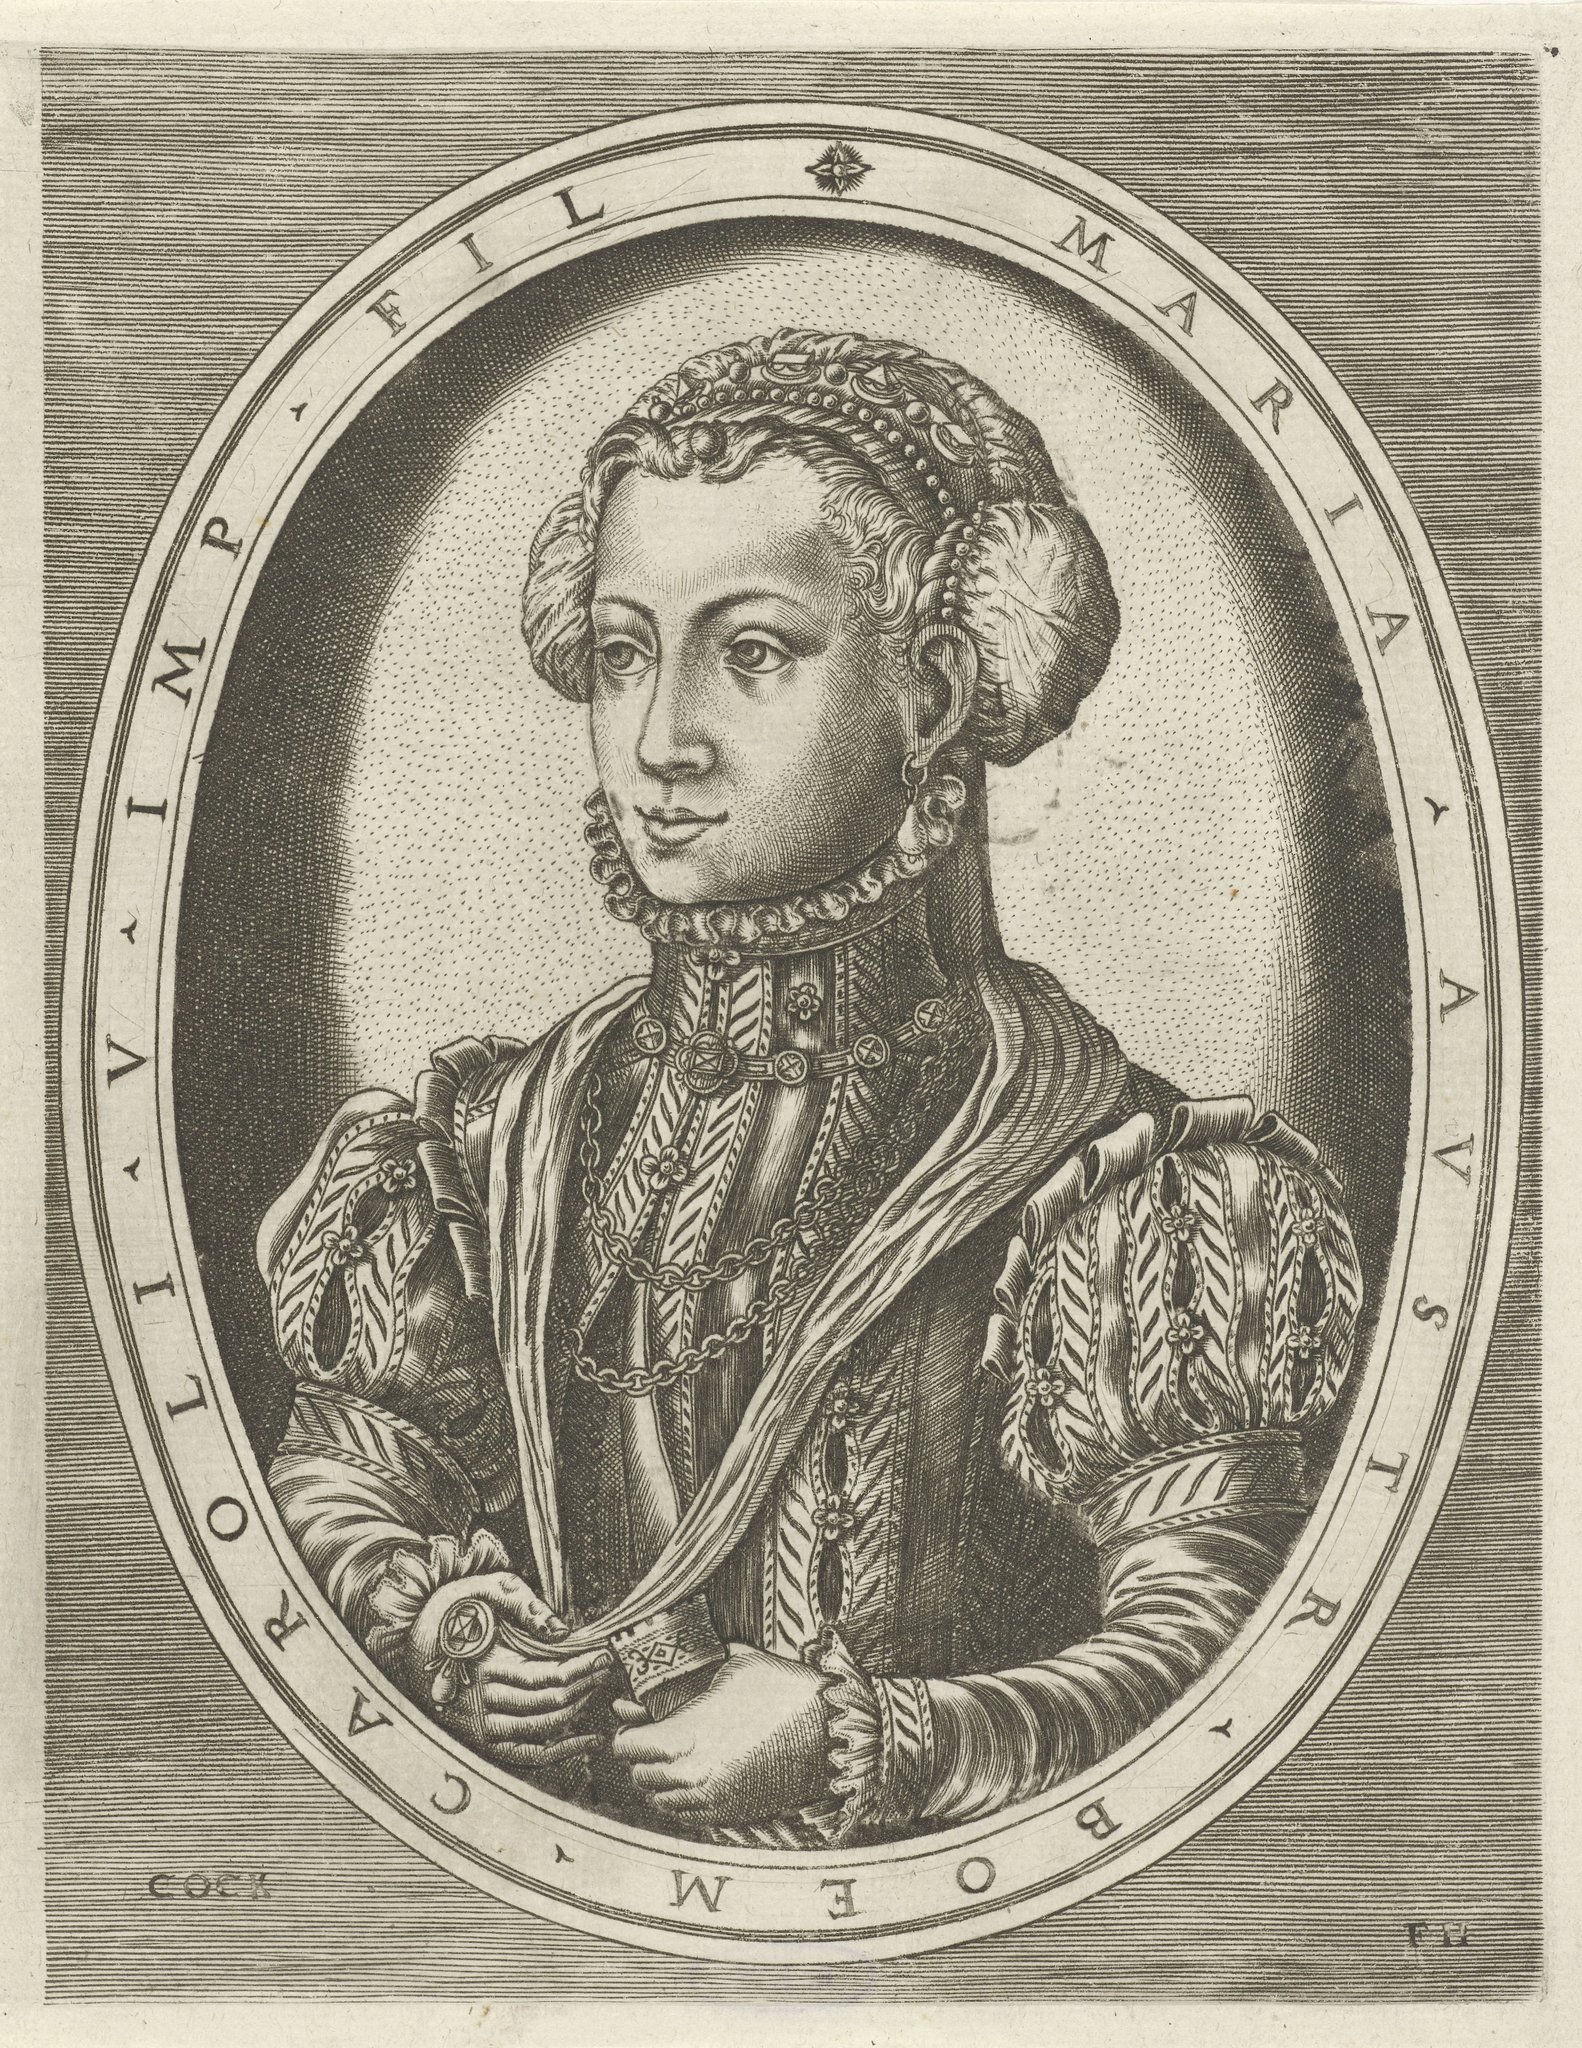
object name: print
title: Portretten van koningen, koninginnen, prinsen en prinsessen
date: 1546-1562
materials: paper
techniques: engraving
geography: antwerp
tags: maria (koningin van bohemen)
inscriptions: collector's mark: Lugt 2228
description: Portret van Maria, koningin van Bohemen, ten halven lijve naar links met een handschoen in haar linkerhand en een hanger in haar rechterhand, in een ovale lijst met randschrift in het Latijn.